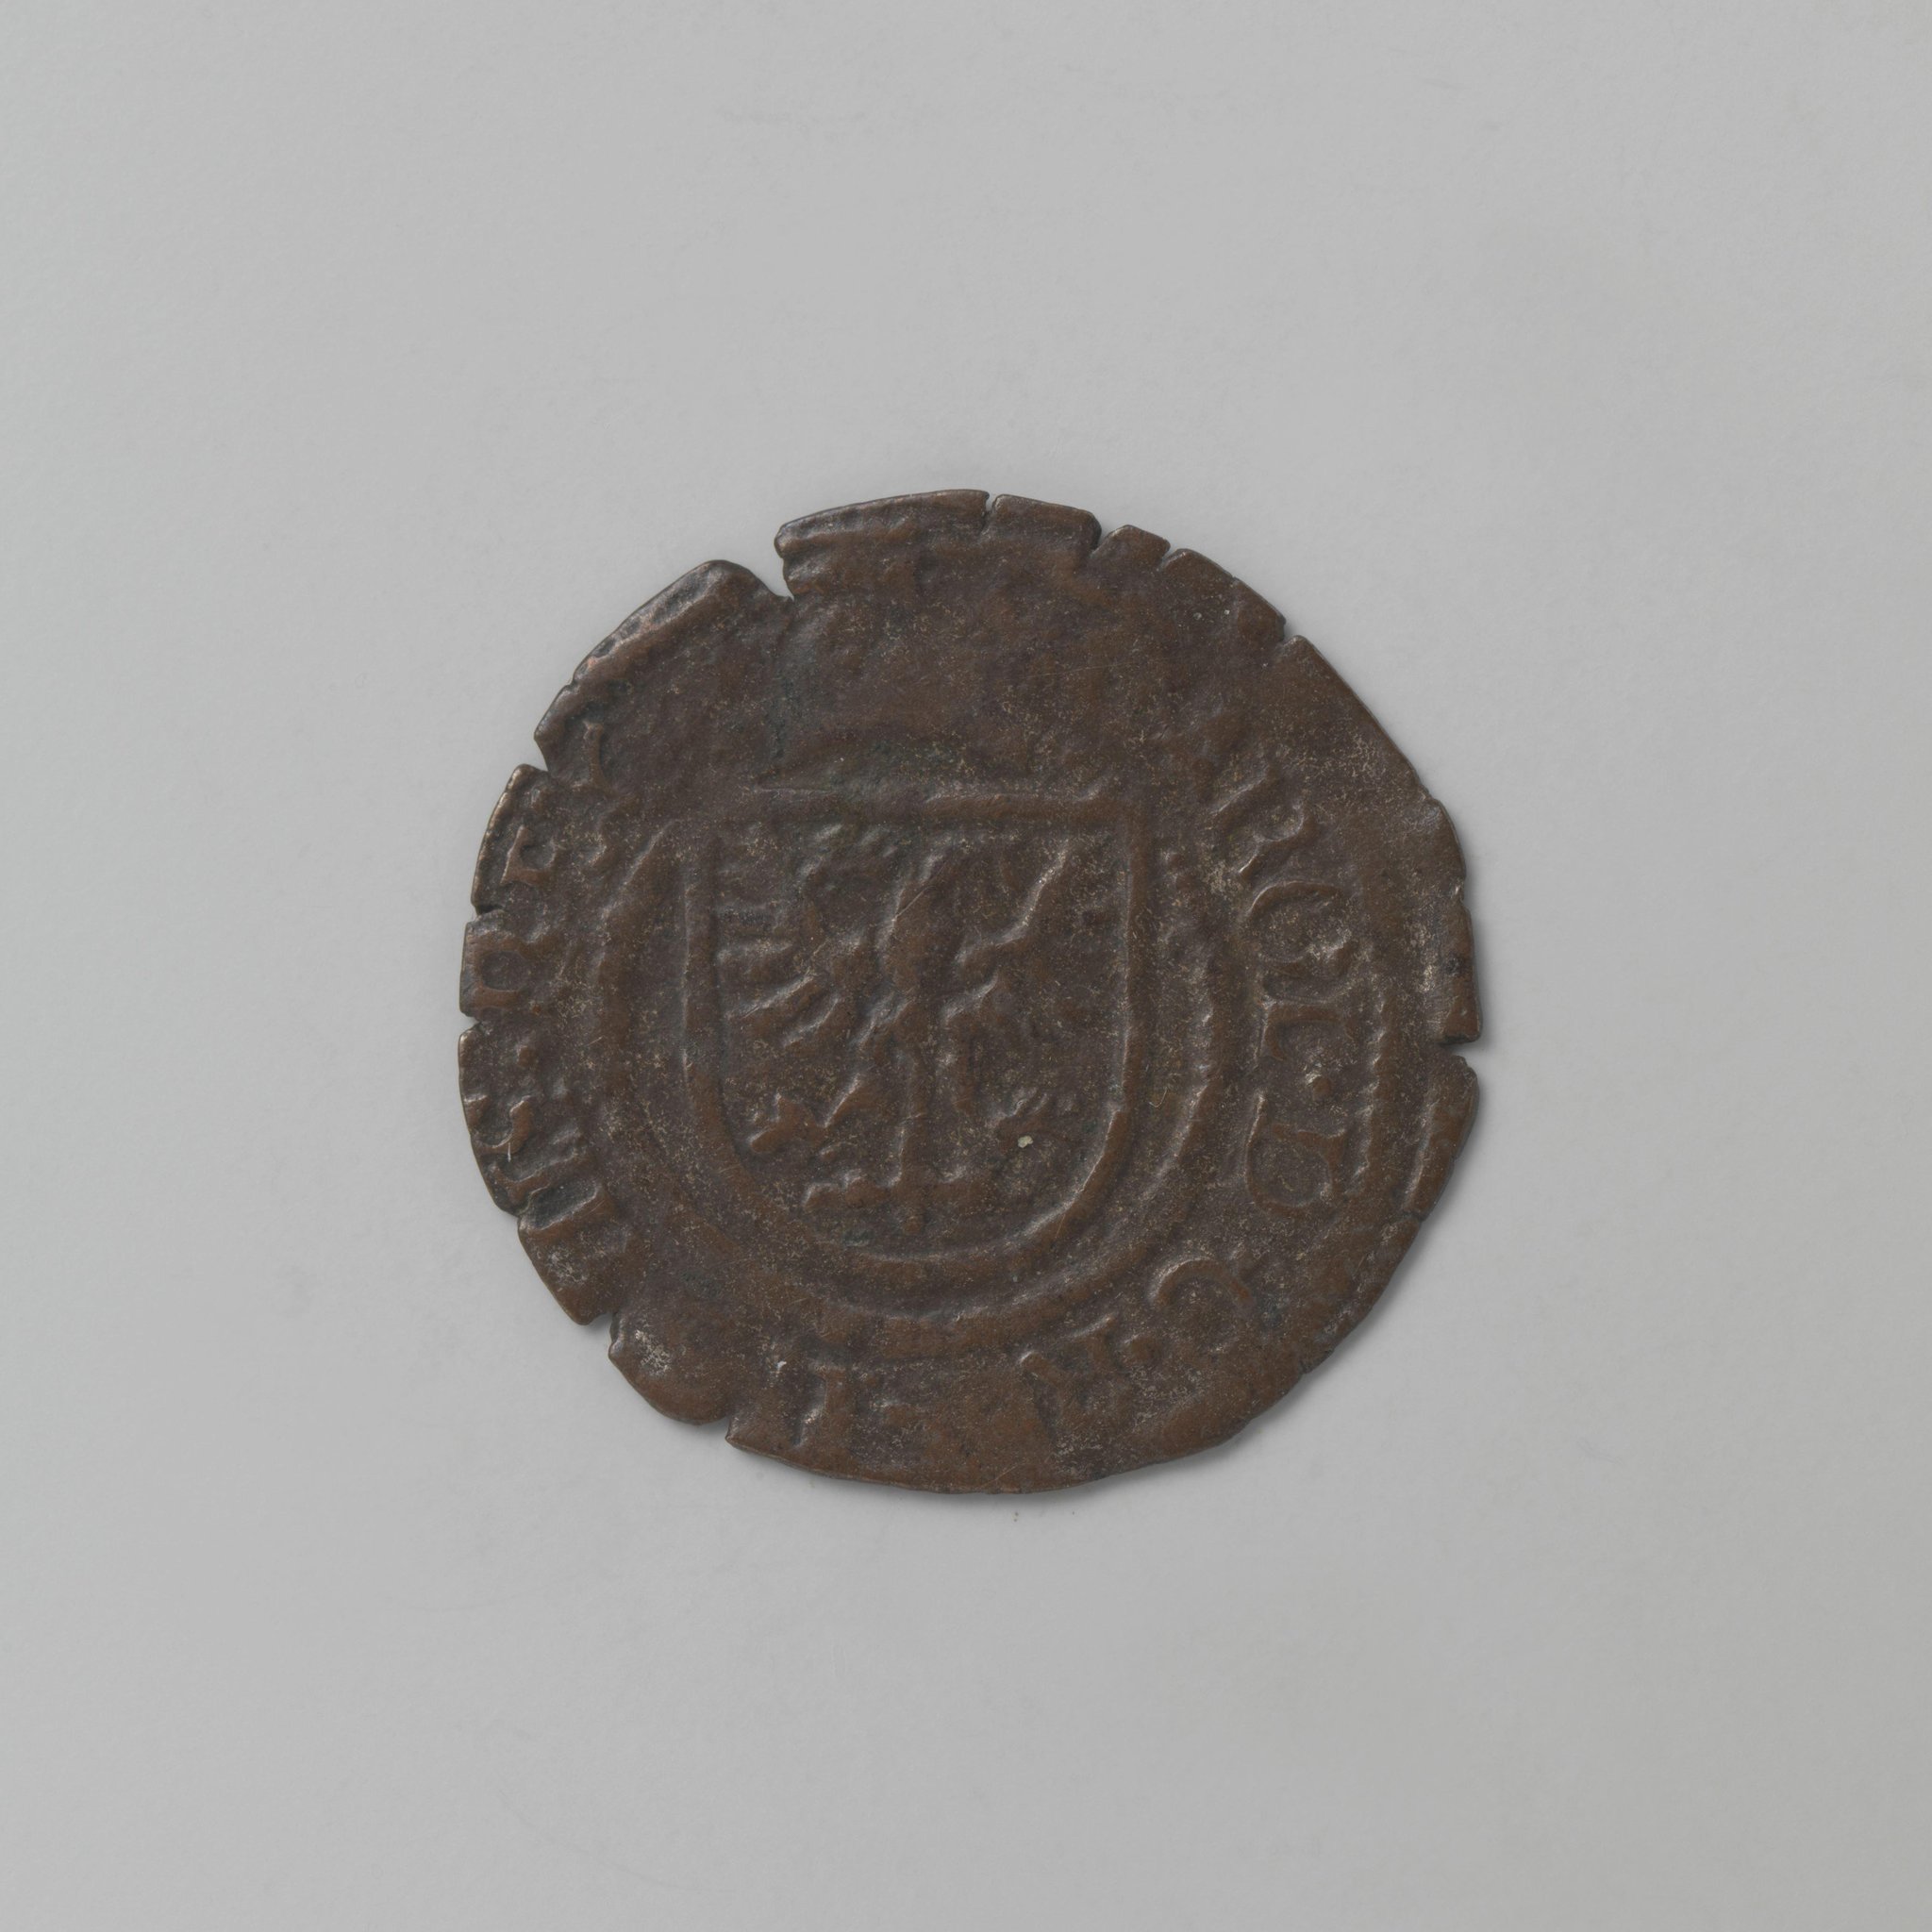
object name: coin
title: Gelderse Hollandse penning van keizer Karel V, 1515-1555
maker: charles v (holy roman emperor and king of spain)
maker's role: keizer, koning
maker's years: 1500-1558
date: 1544-1552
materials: copper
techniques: striking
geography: gelderland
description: Koperen munt. Voorzijde: gekroond keizerlijk wapenschild. Keerzijde: lang dubbellijnig kruis, in hart roos.